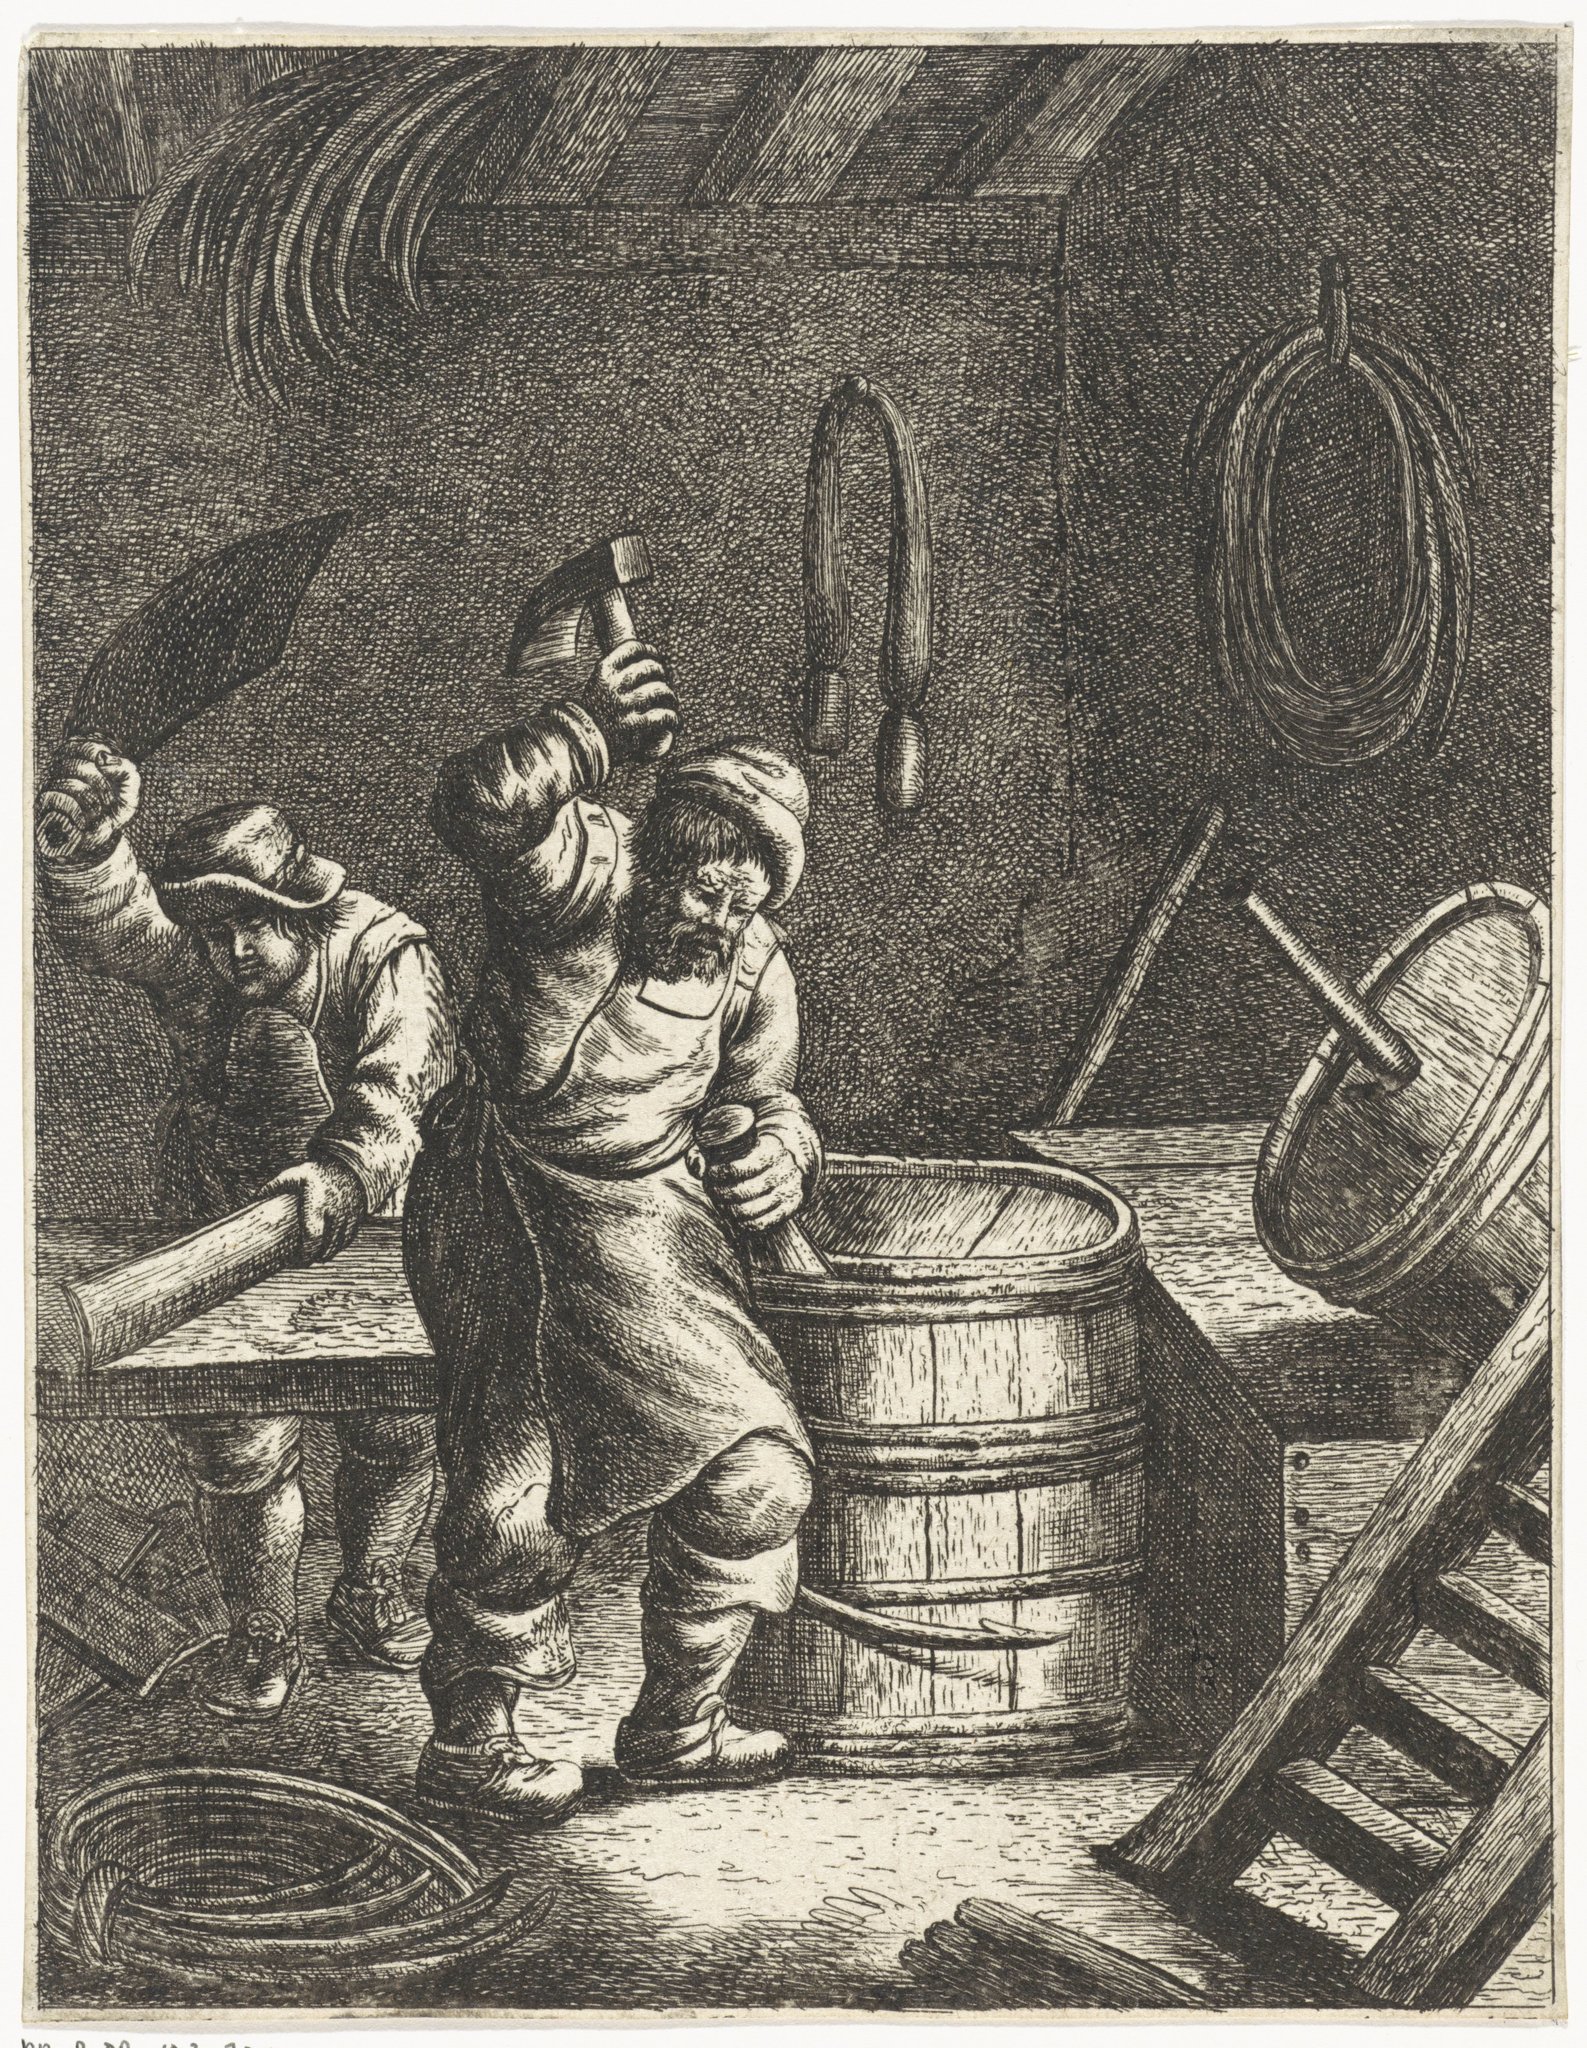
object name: print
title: Kuiper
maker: Anonymous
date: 1635-1685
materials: paper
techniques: engraving, etching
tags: craft-production, skilled handiwork, wooden container: barrel, cask, bucket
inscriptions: collector's mark: Lugt 2228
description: Kopie naar de prent uit de serie 'Beroepen' van Jan Gillisz. van Vliet.